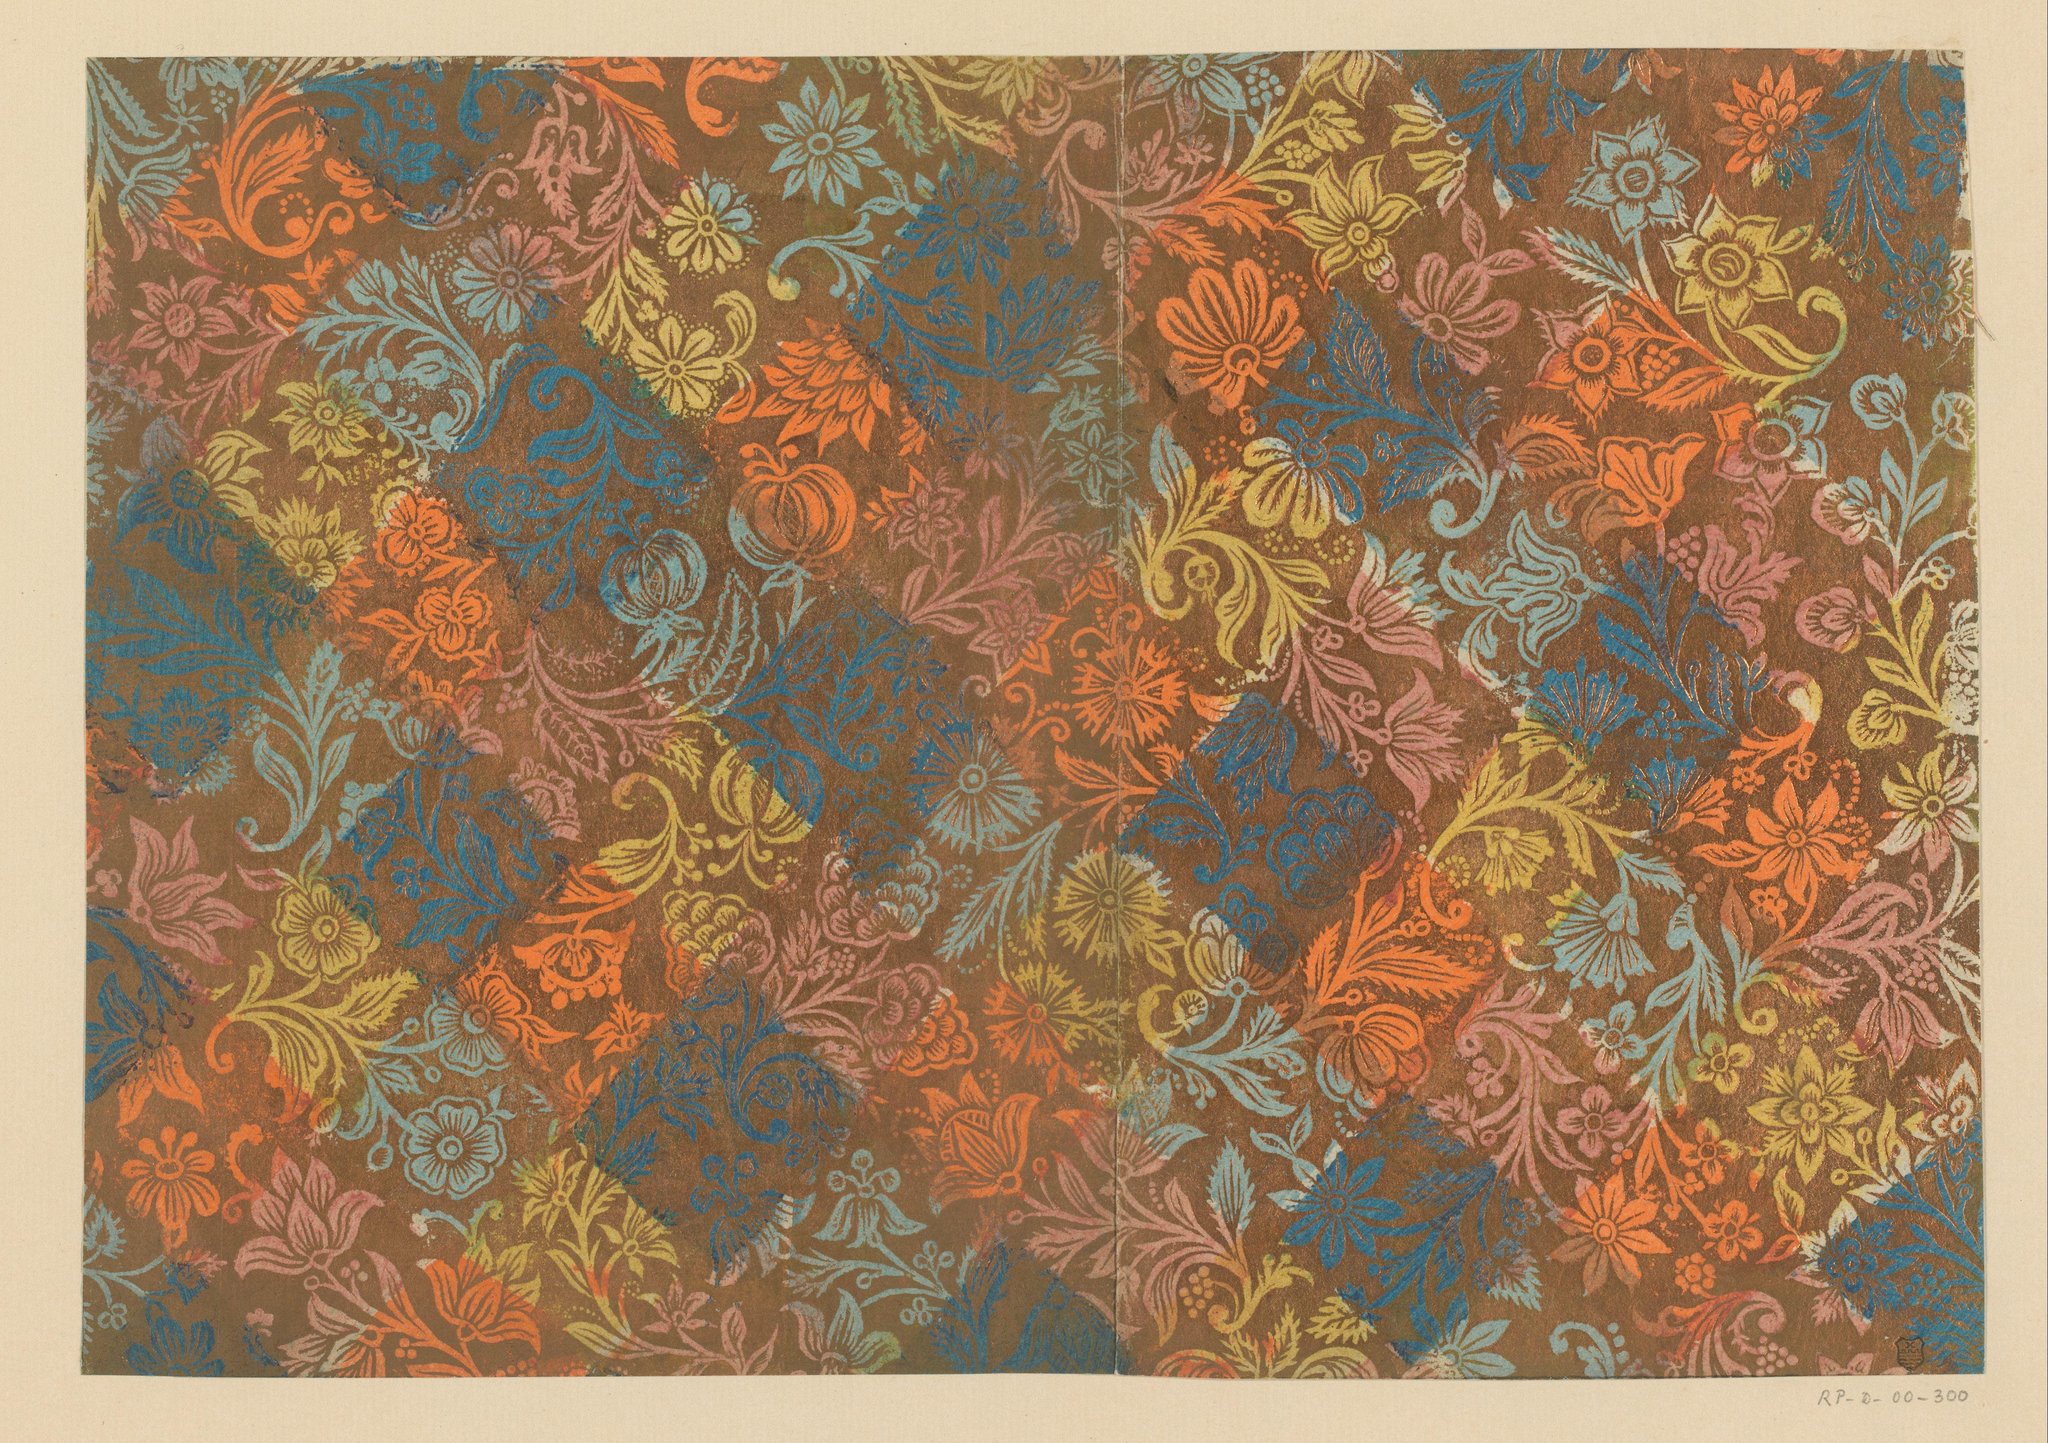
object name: brocade paper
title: Blad met bloemen en vruchten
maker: Anonymous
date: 1700-1800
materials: gold leaf, paint, paper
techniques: relief print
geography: germany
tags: ornament derived from plant forms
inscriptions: collector's mark: Lugt 2760